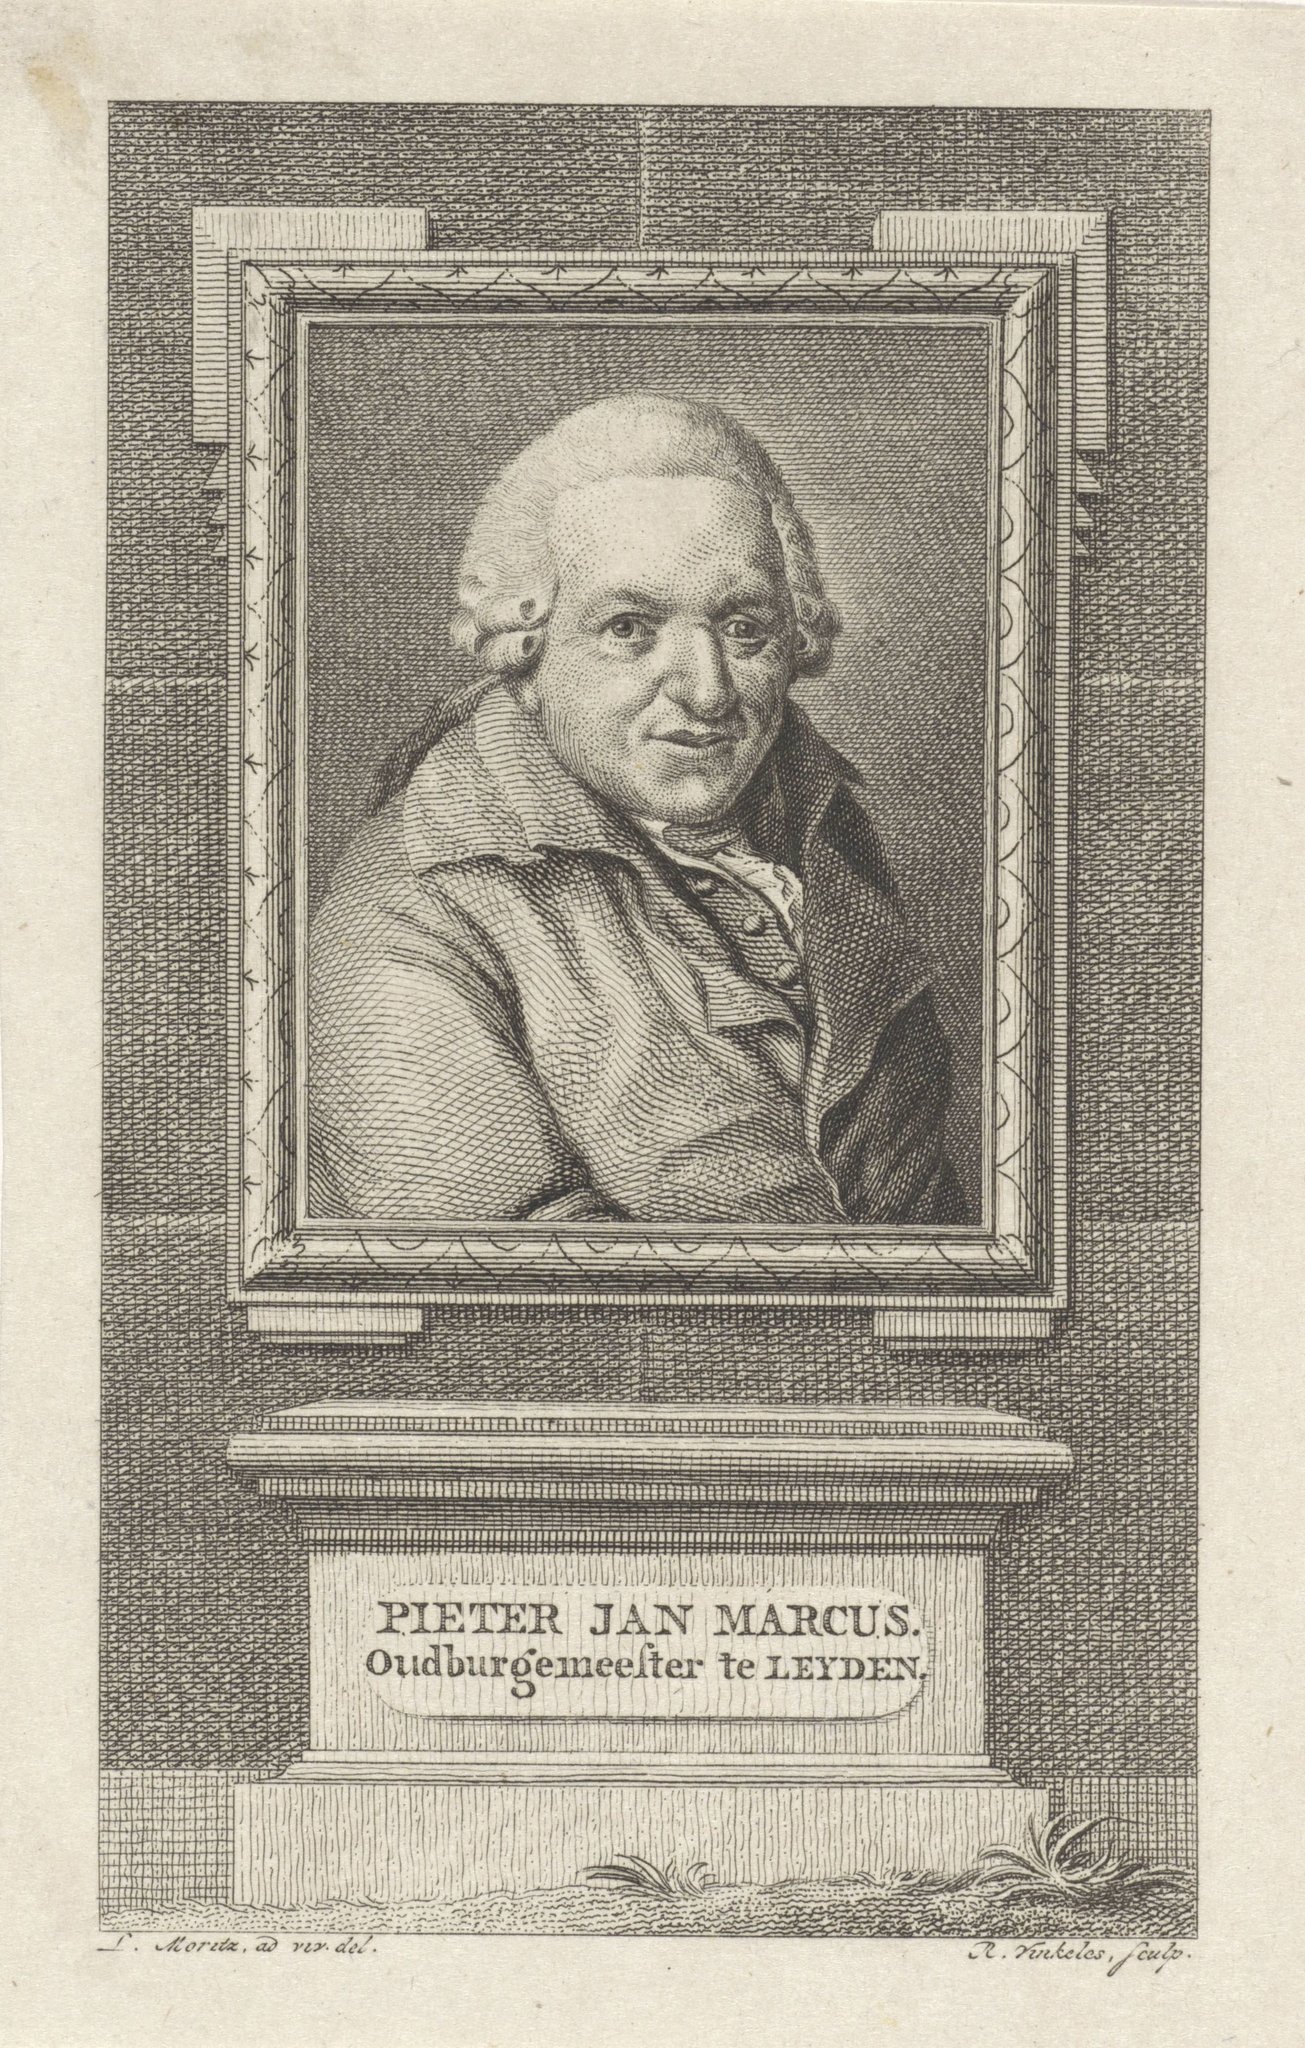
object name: print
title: Portret van Pieter Jan Marcus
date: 1786-1809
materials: paper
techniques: etching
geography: amsterdam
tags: pieter jan marcus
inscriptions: collector's mark: Lugt 2228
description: Prent ook gebruikt als boekillustratie in: Wagenaar, Jan. Vaderlandsche historie, (...) ten vervolge van Wagenaars Vaderlandsche historie. Dl. 1-43. Amsterdam: Johannes Allart, 1786-1809.